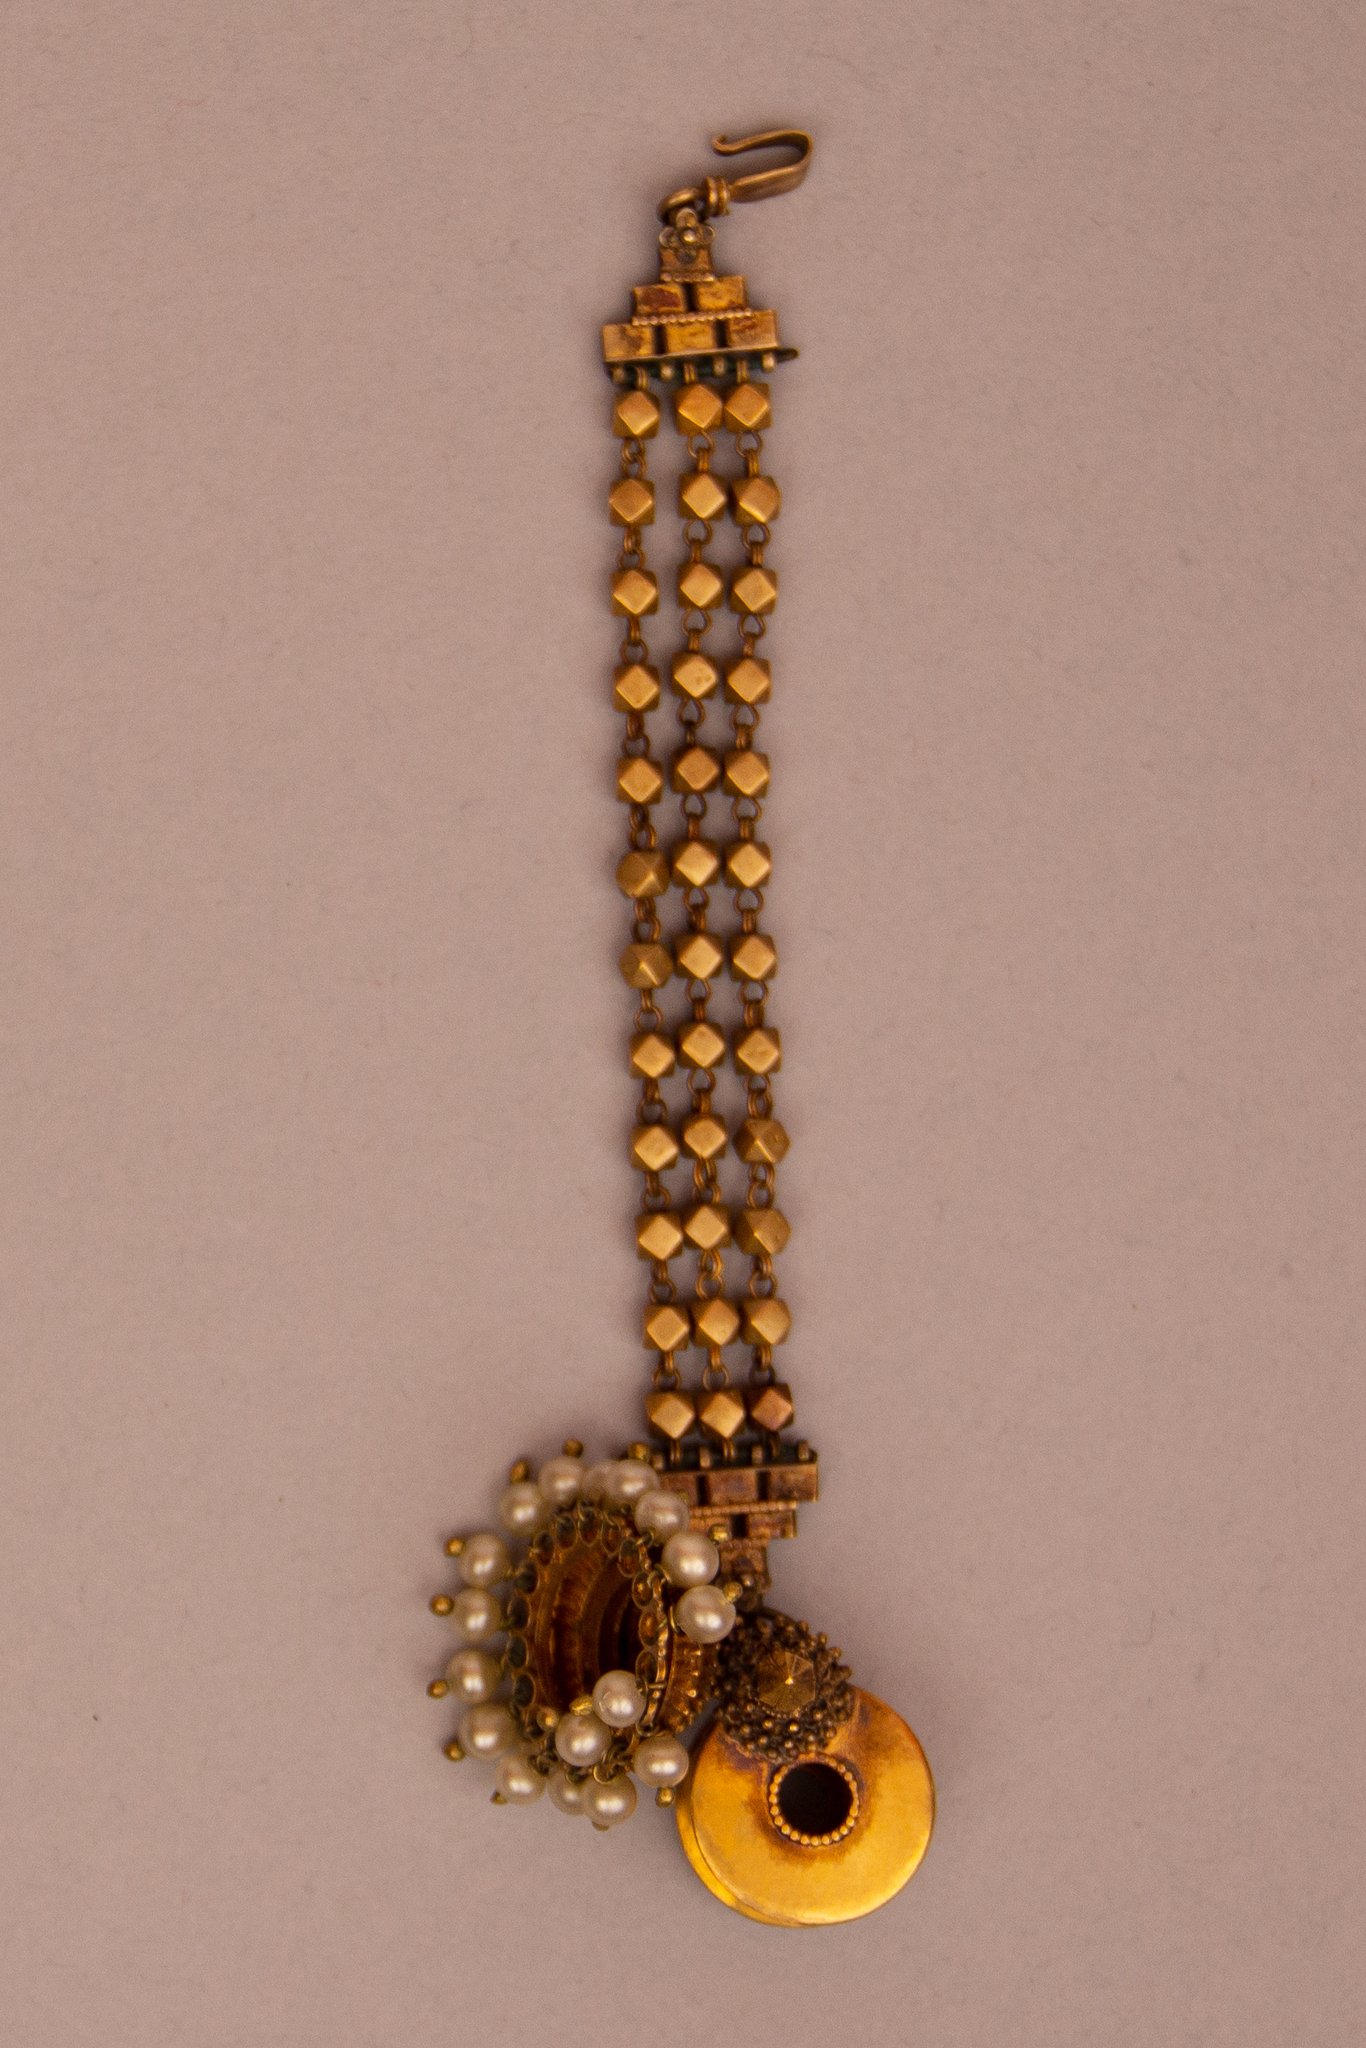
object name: ornament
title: Hair / Ear Ornament, One of a Pair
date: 1701-1900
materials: gold, silver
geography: india